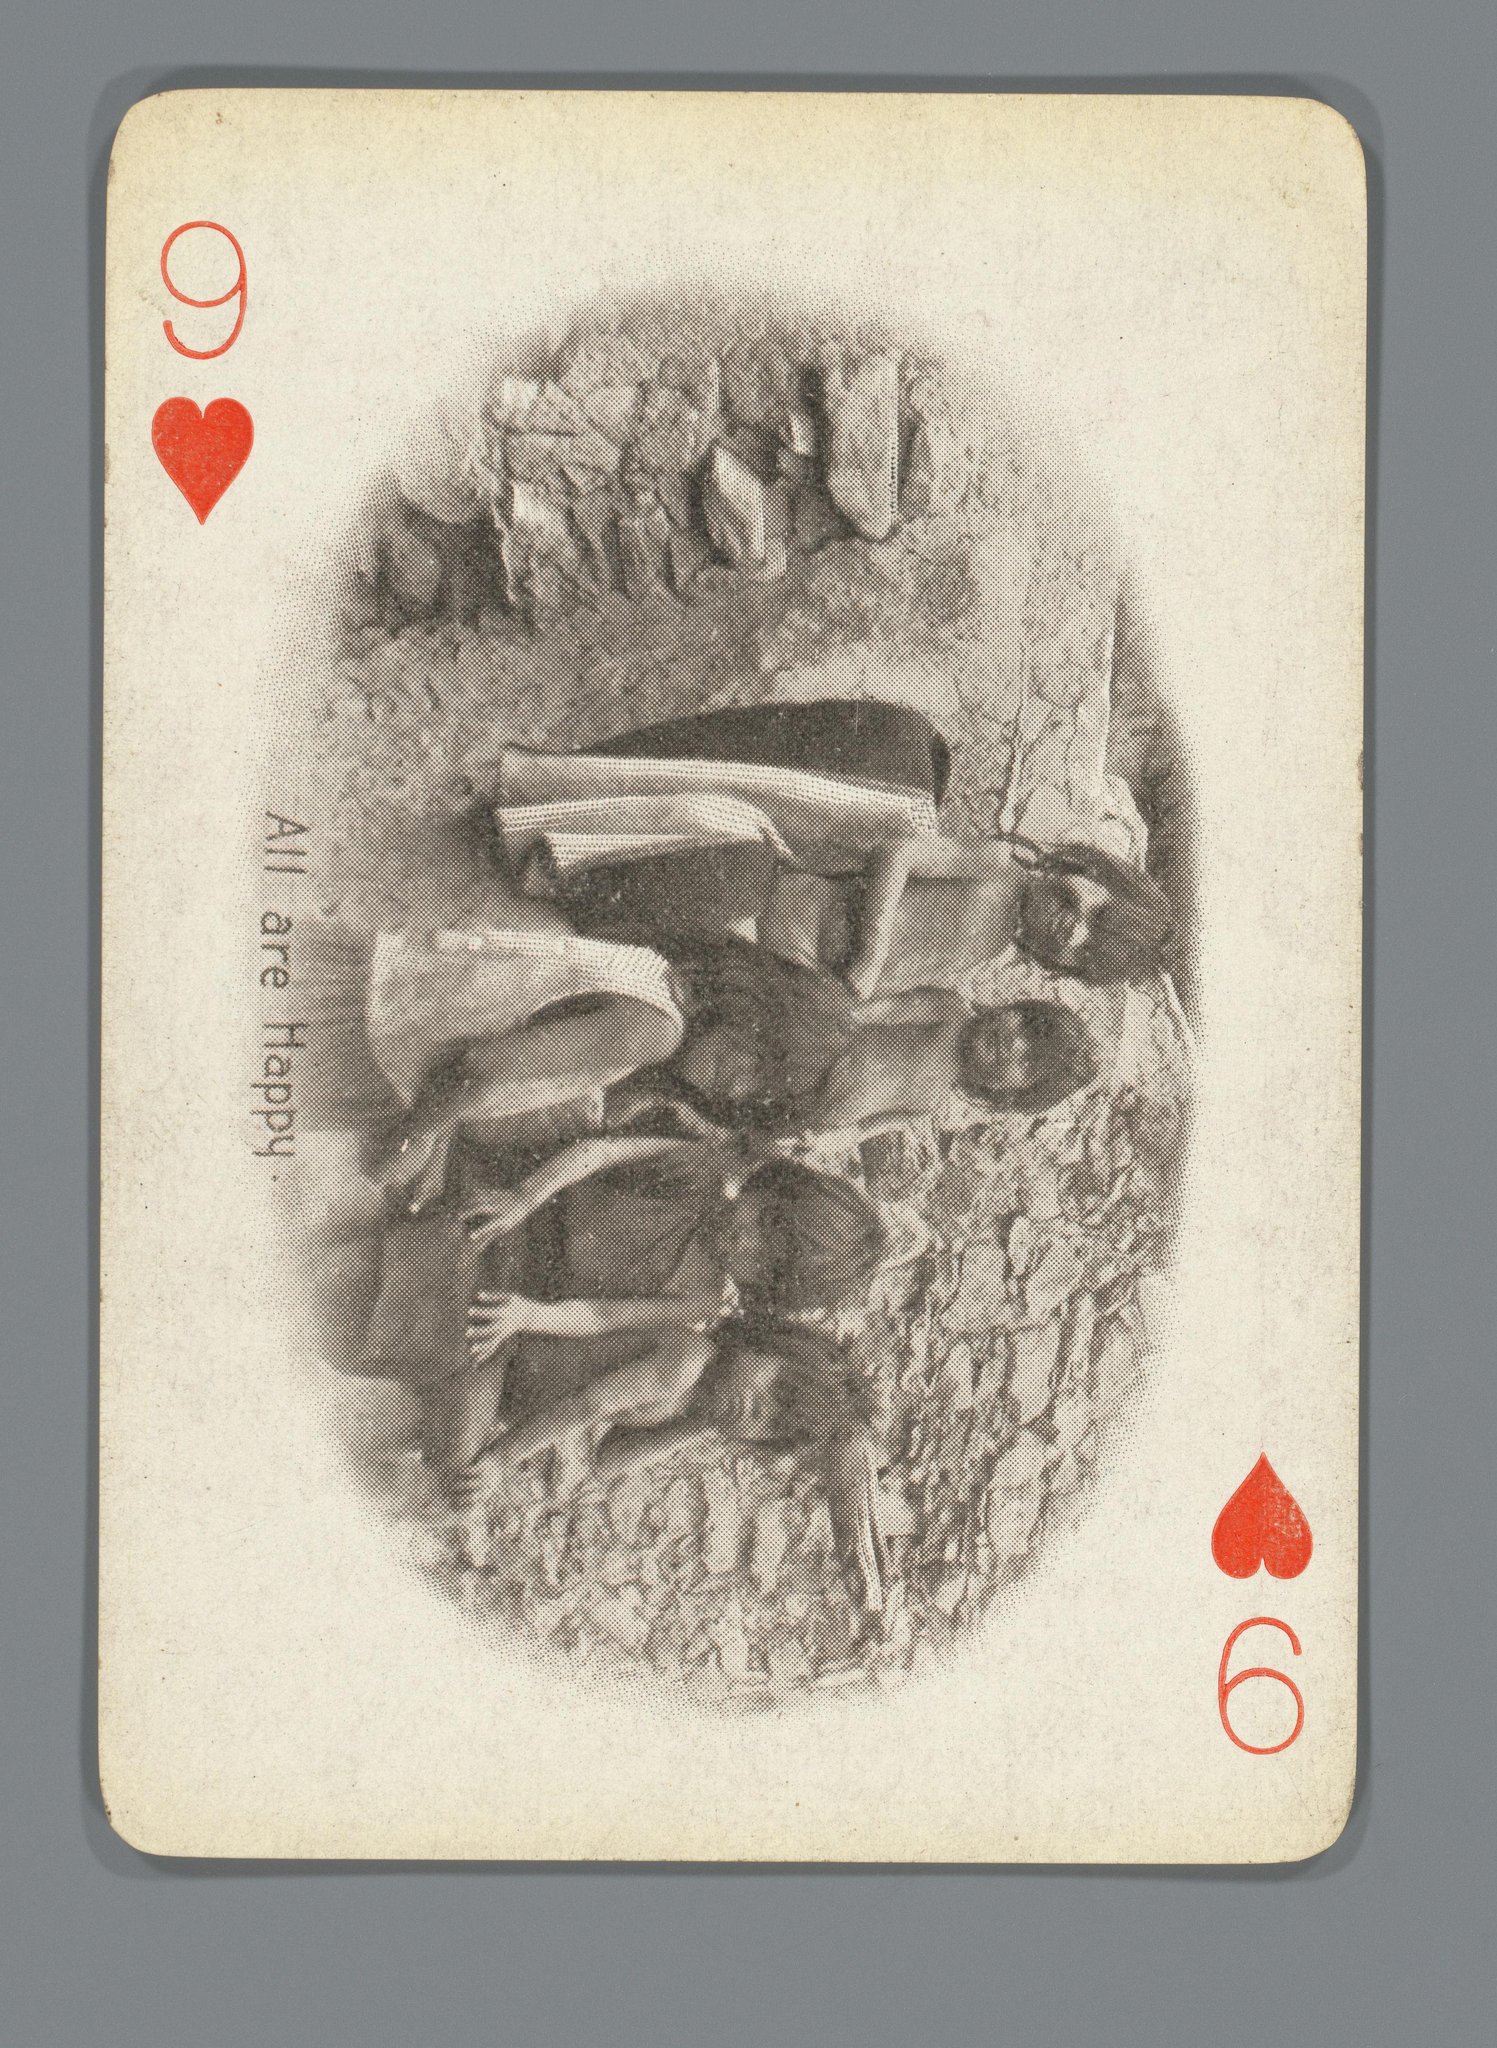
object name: playing card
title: Harten negen met groep kinderen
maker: adam clark vroman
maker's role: fotograaf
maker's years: 1856-1916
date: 1900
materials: paper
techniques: autotype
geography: los angeles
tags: united states of america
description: Speelkaart uit doosje met 53 speelkaarten met afbeeldingen in autotypie van Native Americans. De inhoud bevat een complete set speelkaarten inclusief joker.